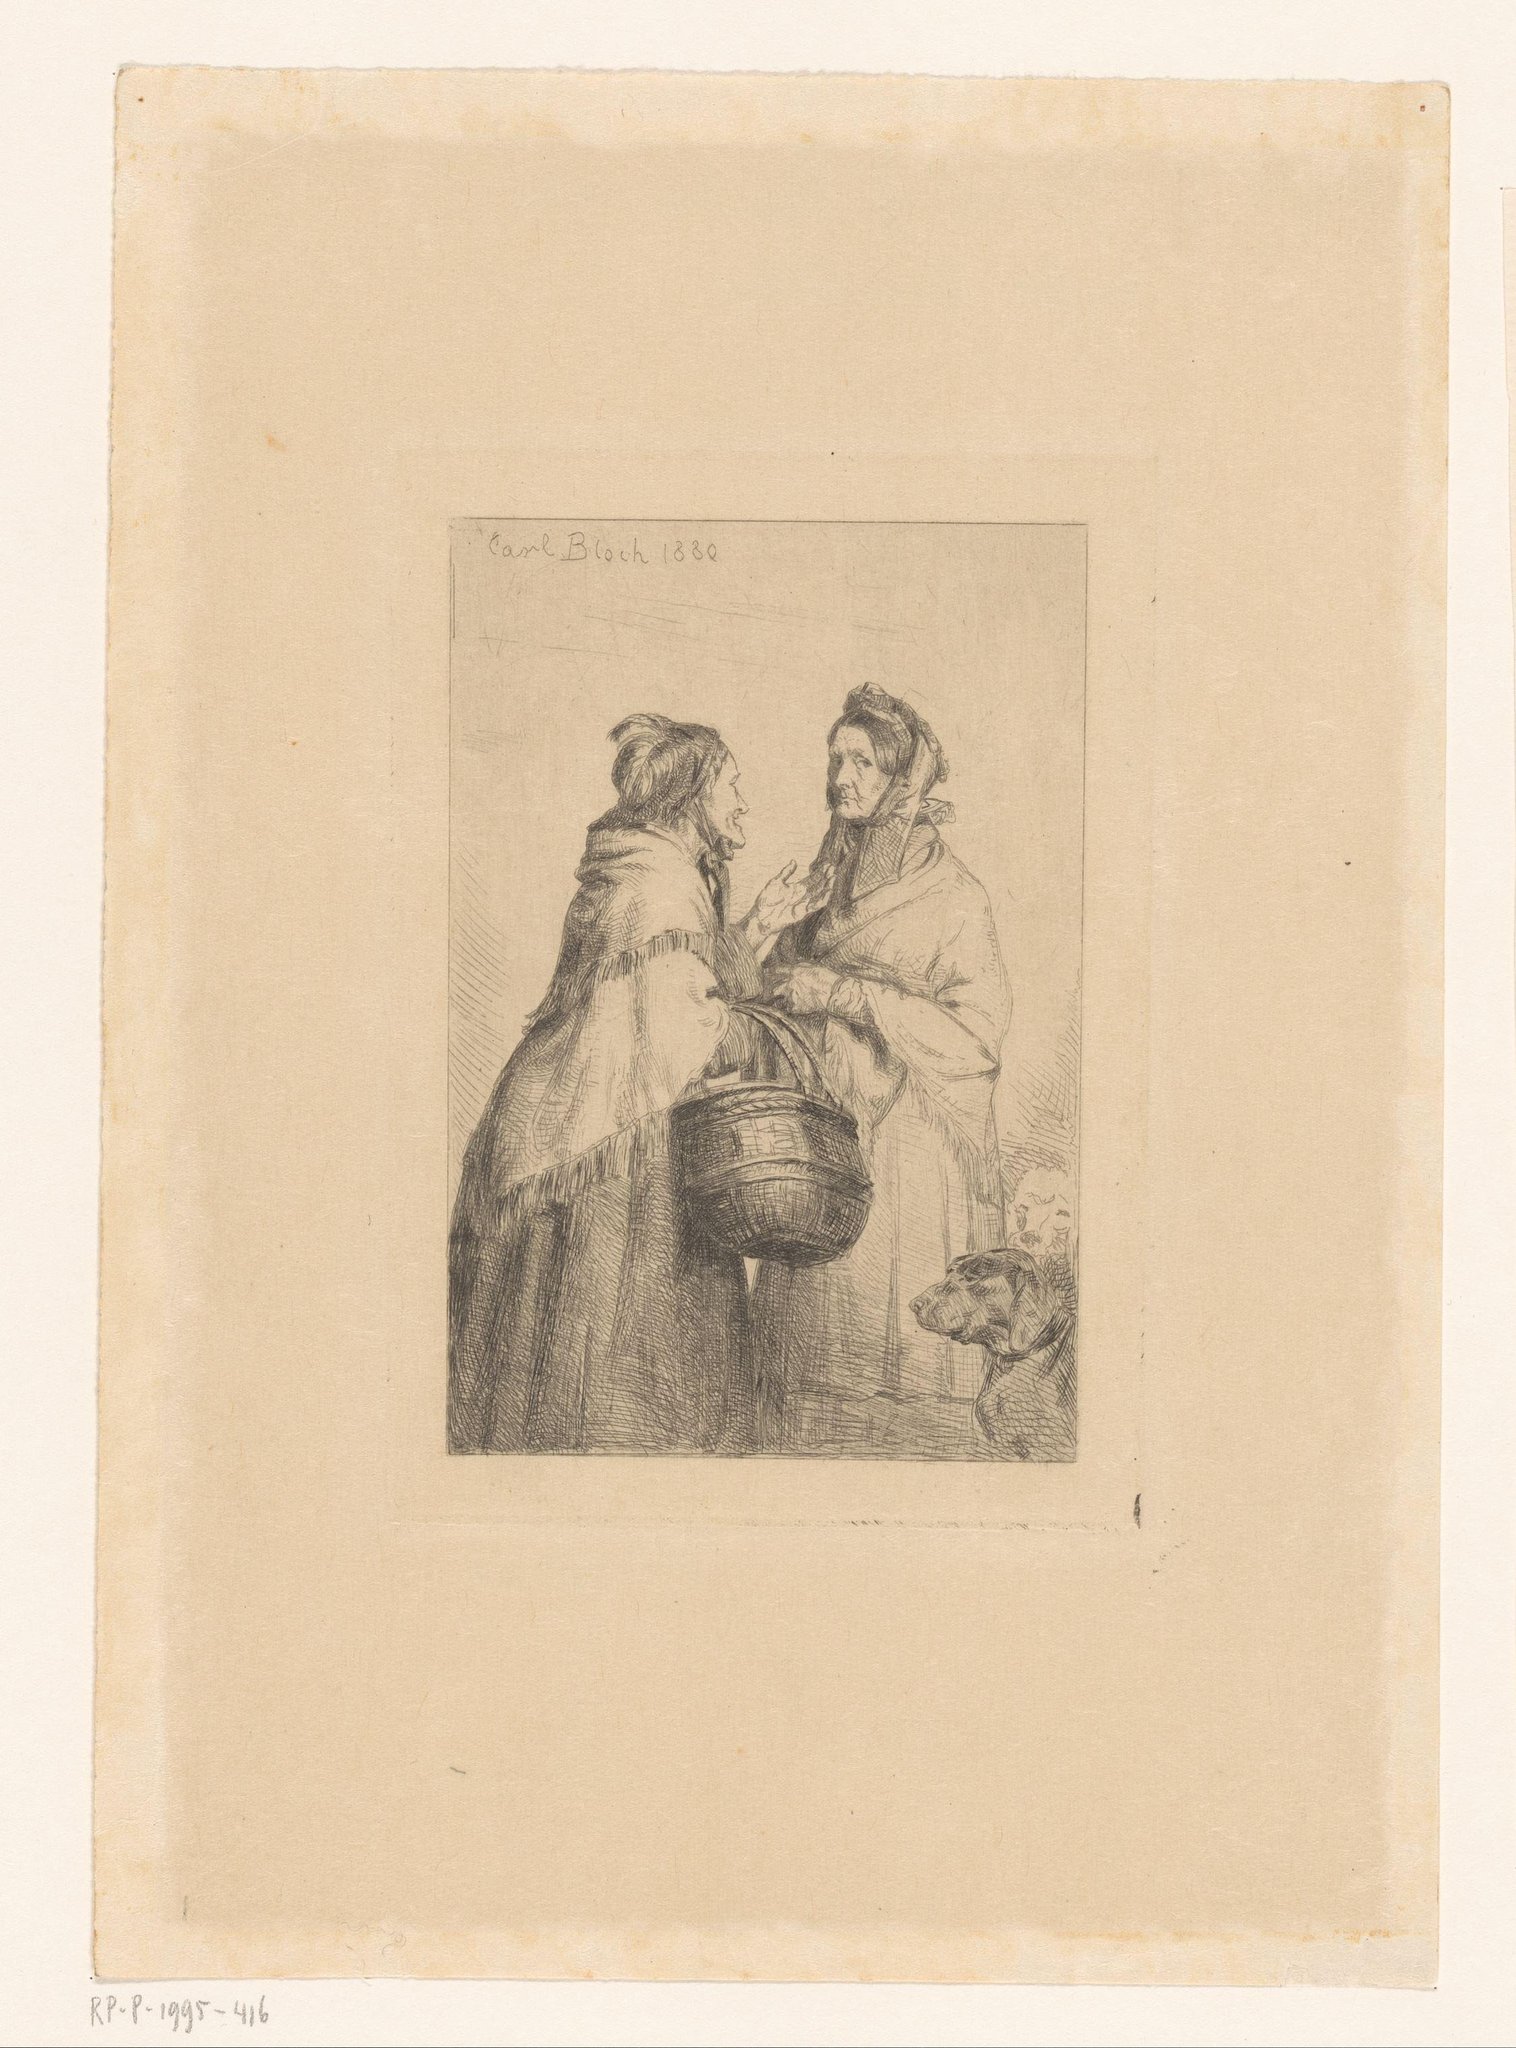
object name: print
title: Twee vrouwen in klederdracht, met elkaar pratend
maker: carl bloch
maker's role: print maker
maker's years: 1834-1890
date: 1880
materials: paper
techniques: drypoint, etching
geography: scandinavia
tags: old woman, dog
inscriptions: signature and date: ‘l.b. gesigneerd en gedateerd Carl Bloch 1880’, collector's mark: Lugt 2228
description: Twee vrouwen in klederdracht staan tegenover elkaar. De linkervrouw, een mand aan haar arm, staat te redeneren. De rechter kijkt de beschouwer vanuit haar ooghoek aan. Achter haar twee honden, waarvan alleen de koppen zijn te zien.